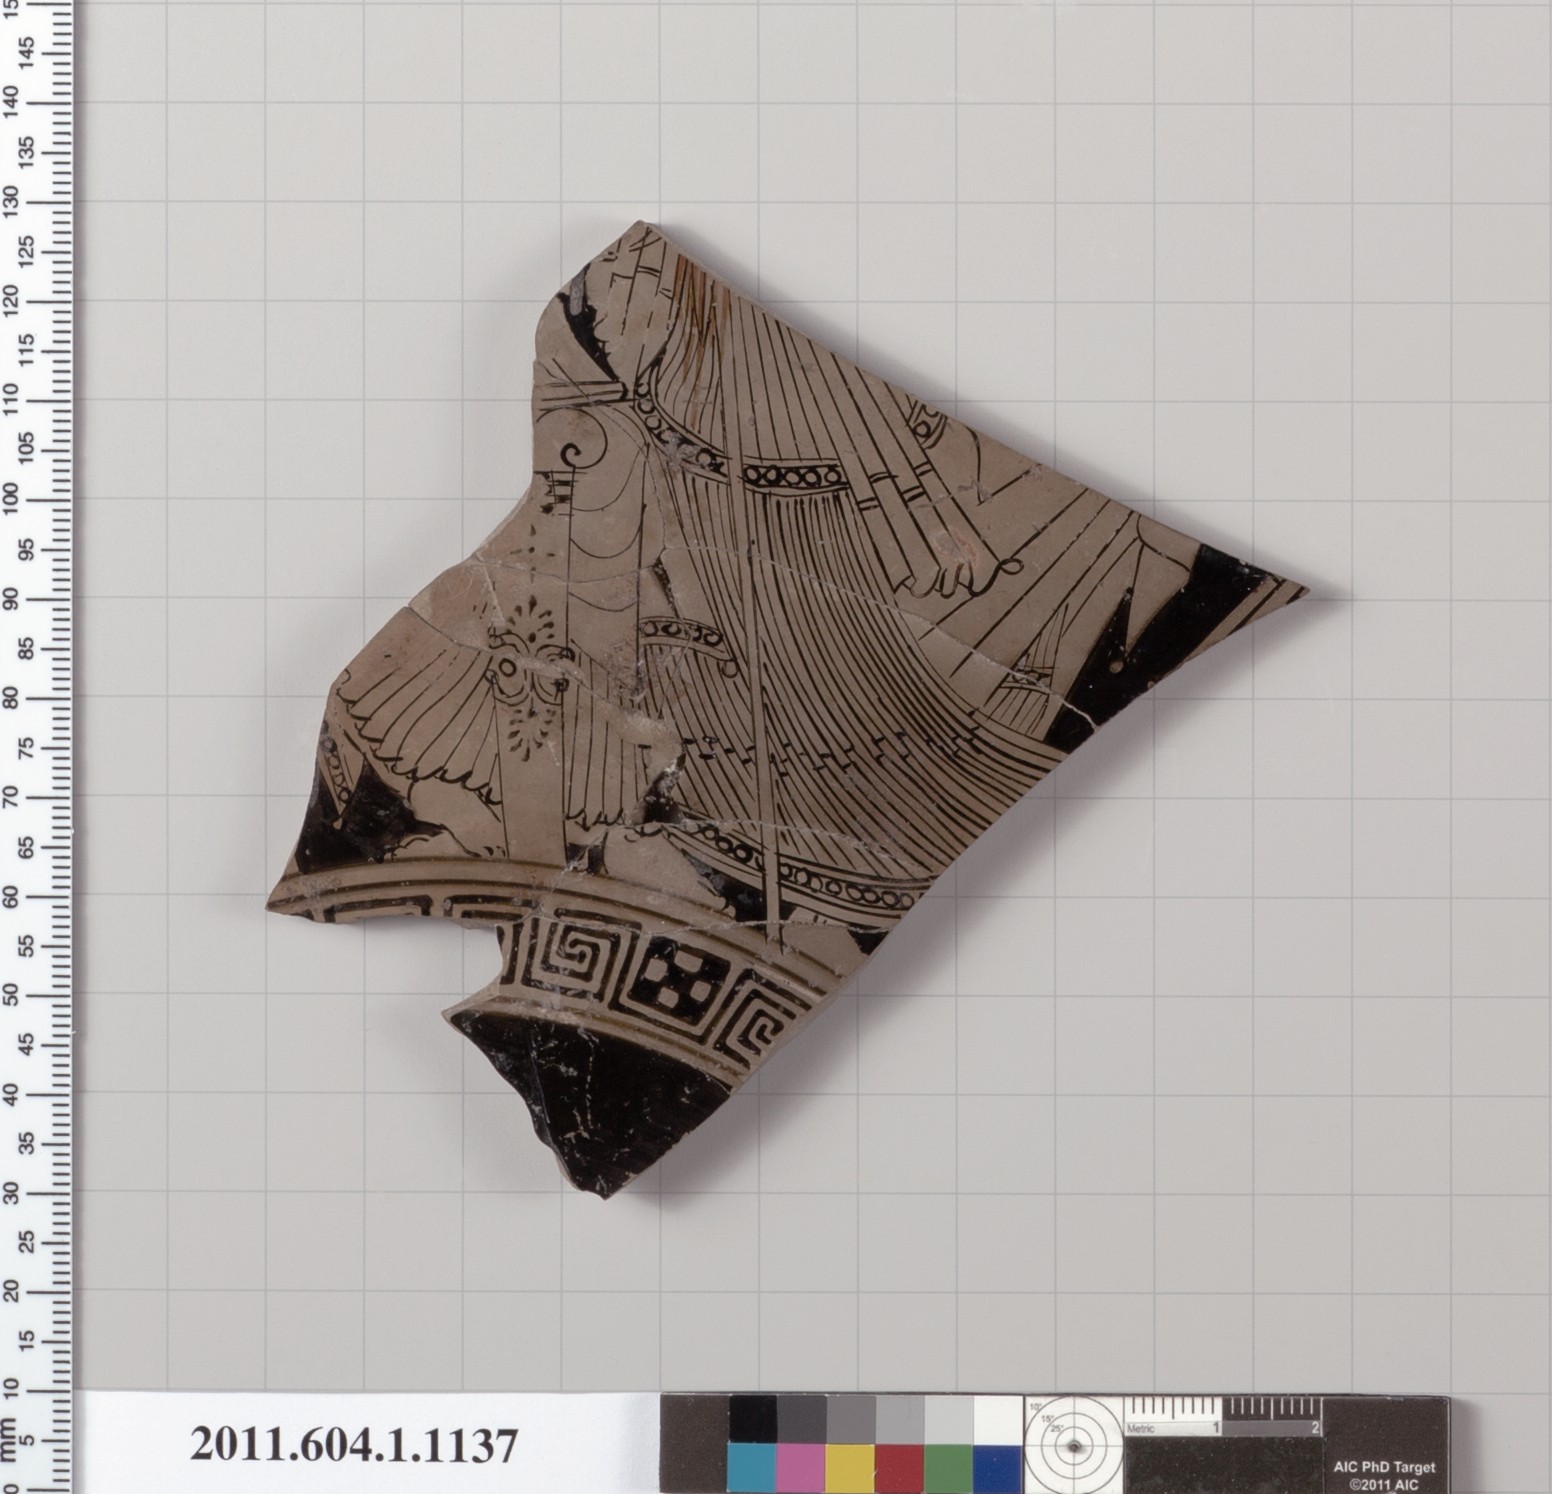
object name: kylix fragment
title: Terracotta fragment of a kylix (drinking cup)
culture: greek, attic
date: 490 BCE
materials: terracotta